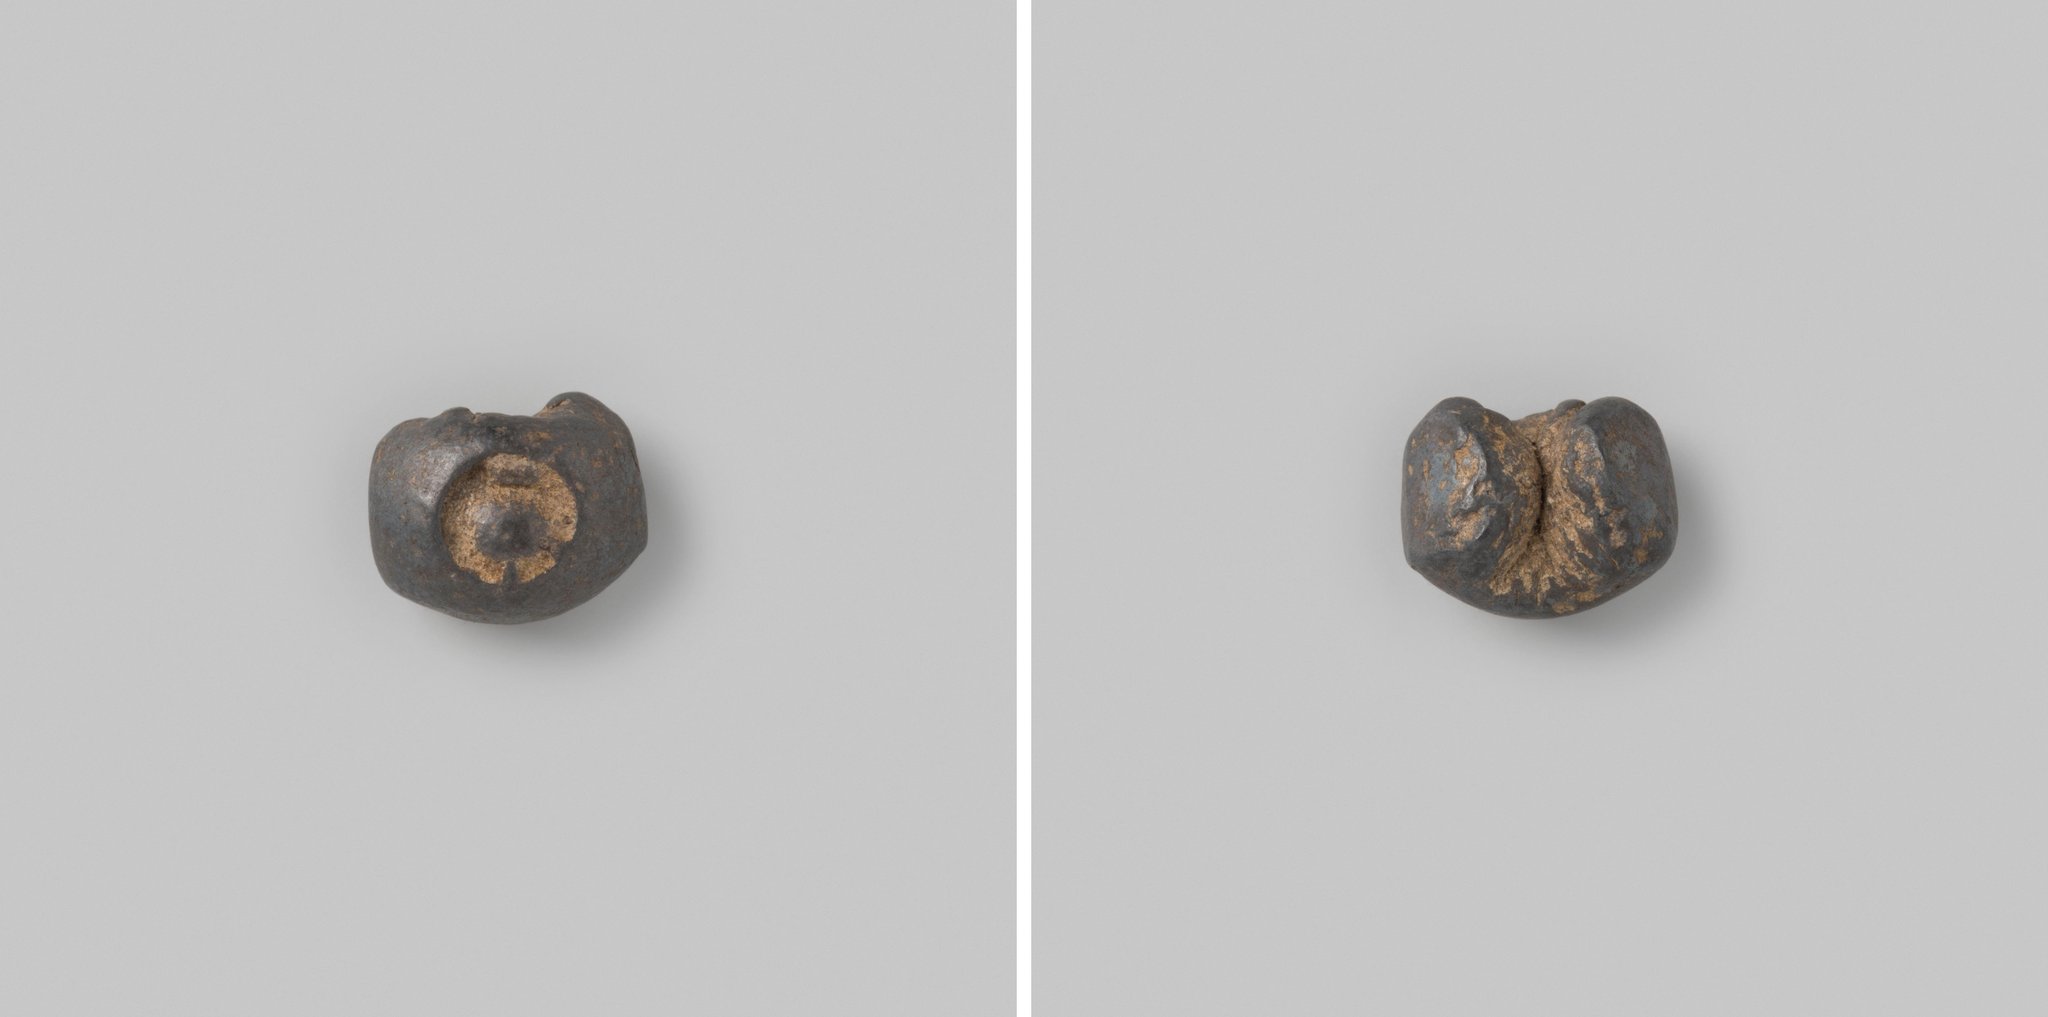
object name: coin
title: 1/8 tical of fuang uit Thailand,1650-1850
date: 1650-1850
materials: silver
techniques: casting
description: Zilveren, korrelvormige munt. voorzien van één instempeling (kra): water pot [?].